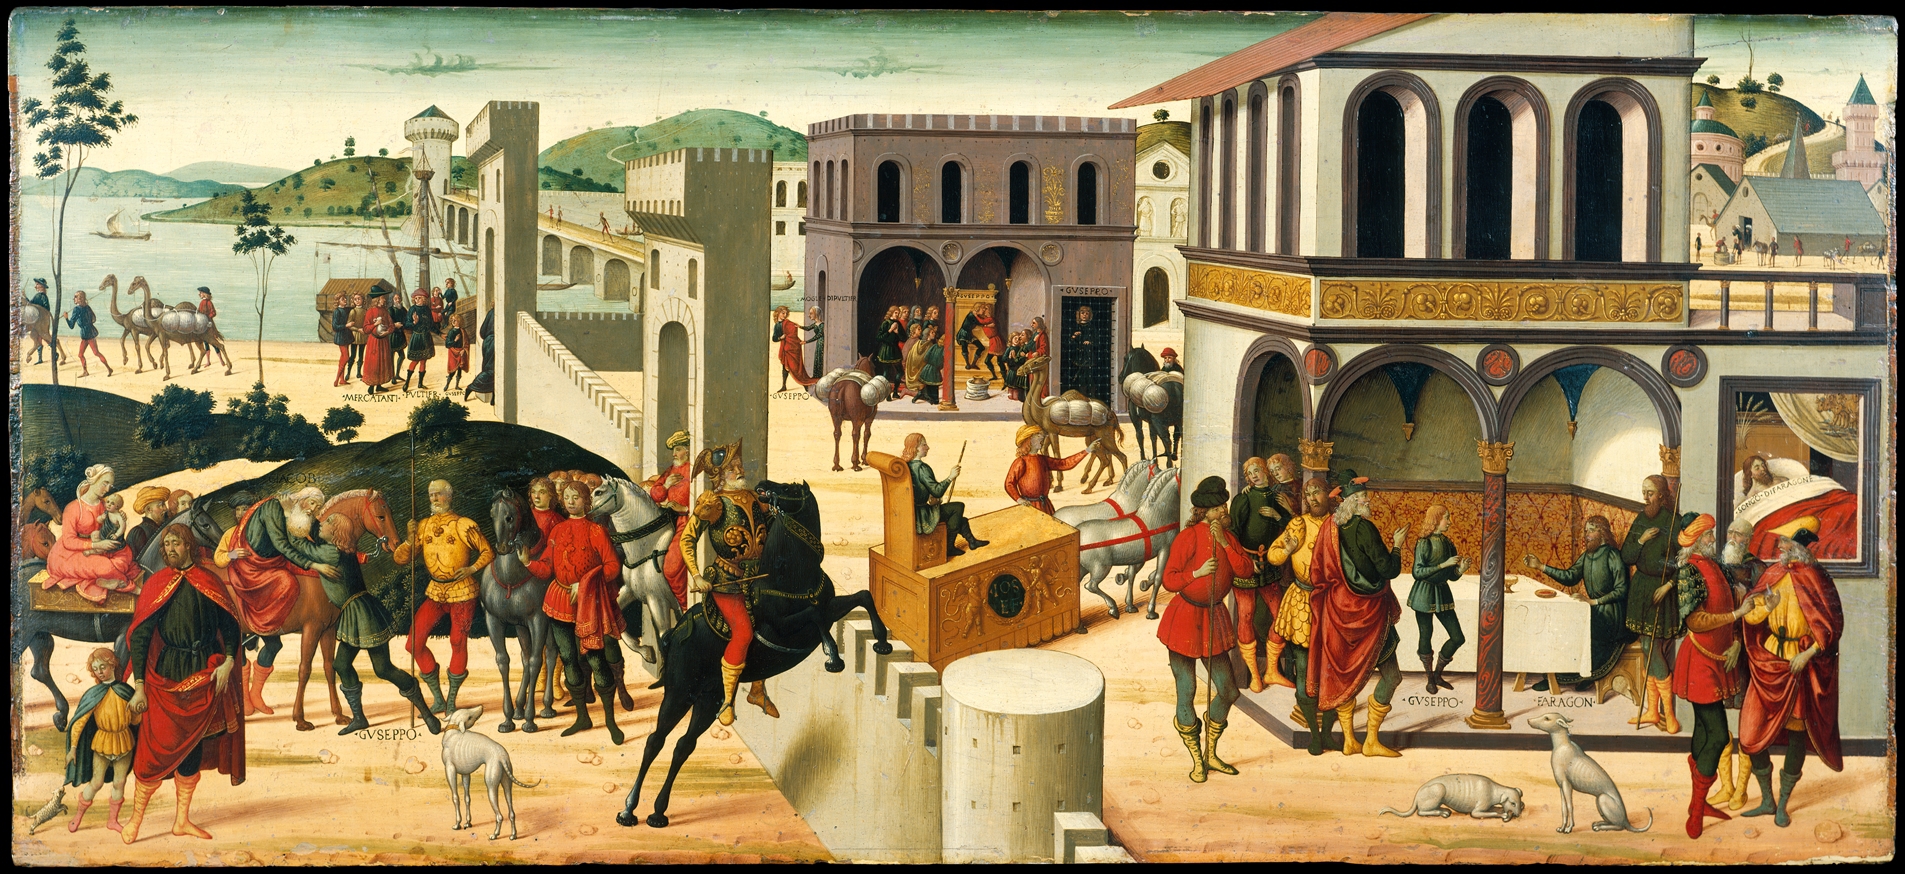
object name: painting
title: The Story of Joseph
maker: biagio d'antonio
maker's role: artist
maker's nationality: italian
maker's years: 1472-1516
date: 1476-1504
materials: paint, wood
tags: men,women,camels,dogs,horses